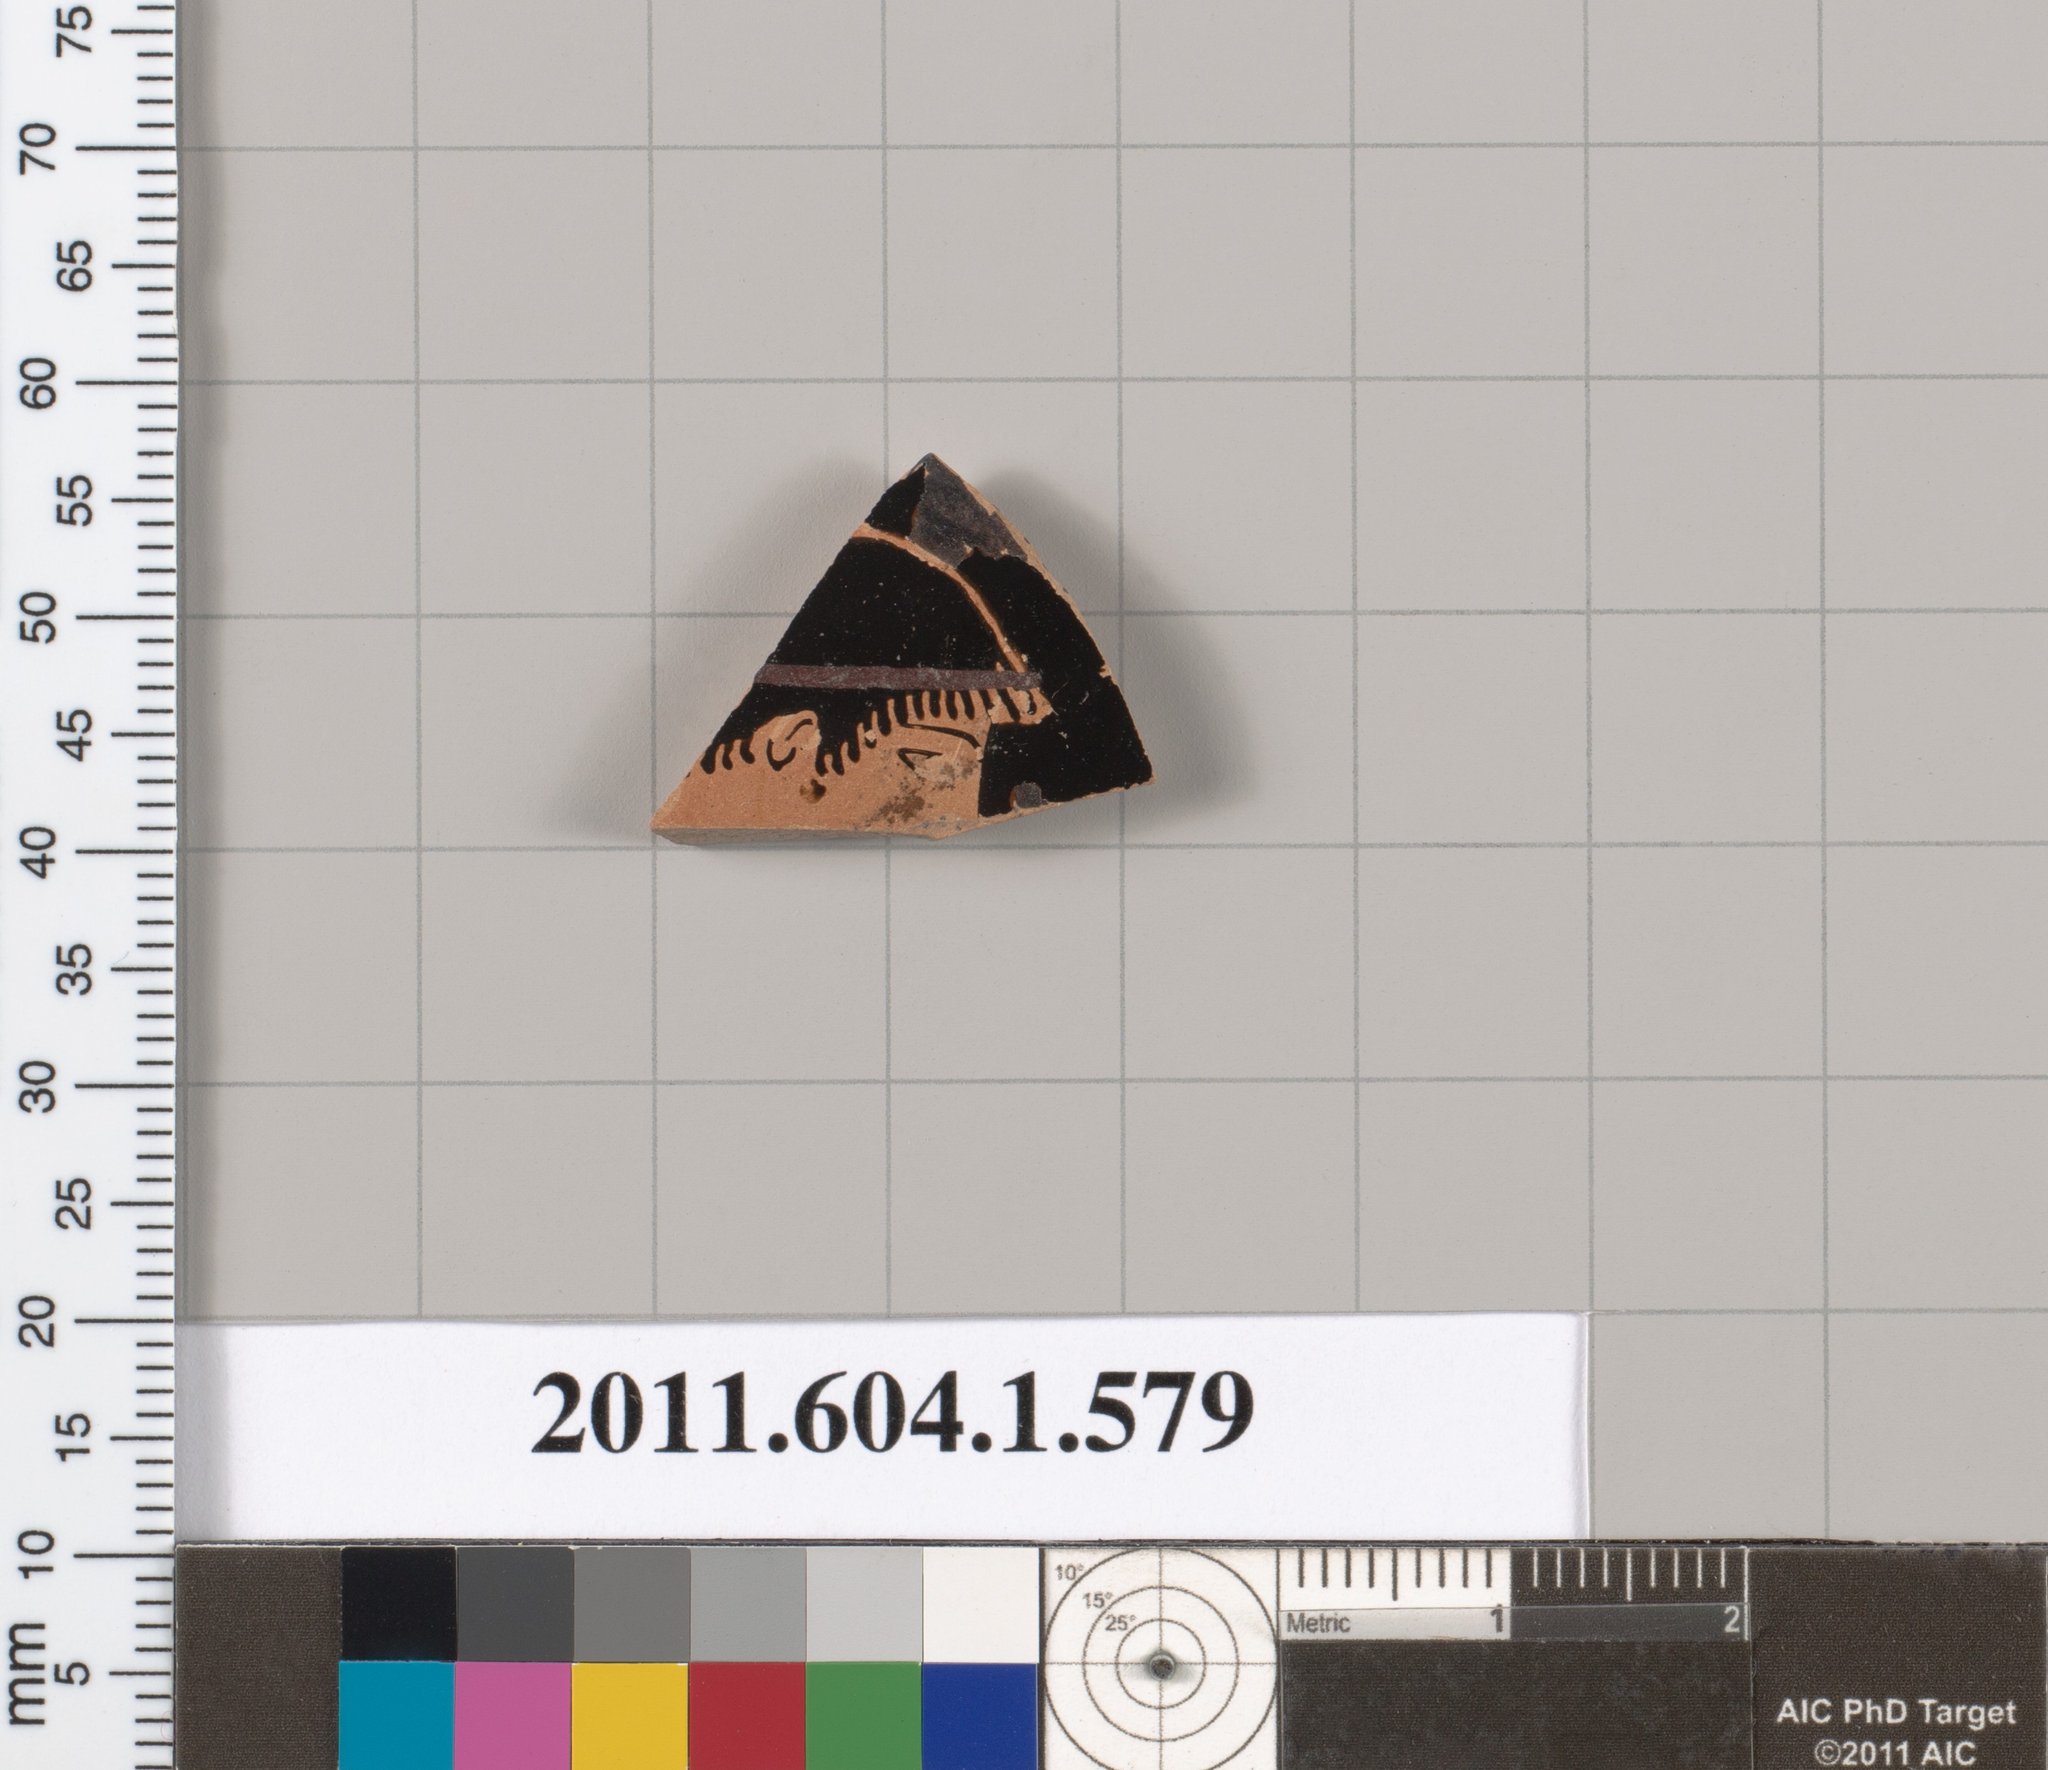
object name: kylix fragment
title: Terracotta fragment of a kylix (drinking cup)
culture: greek, attic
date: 534-501 BCE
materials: terracotta